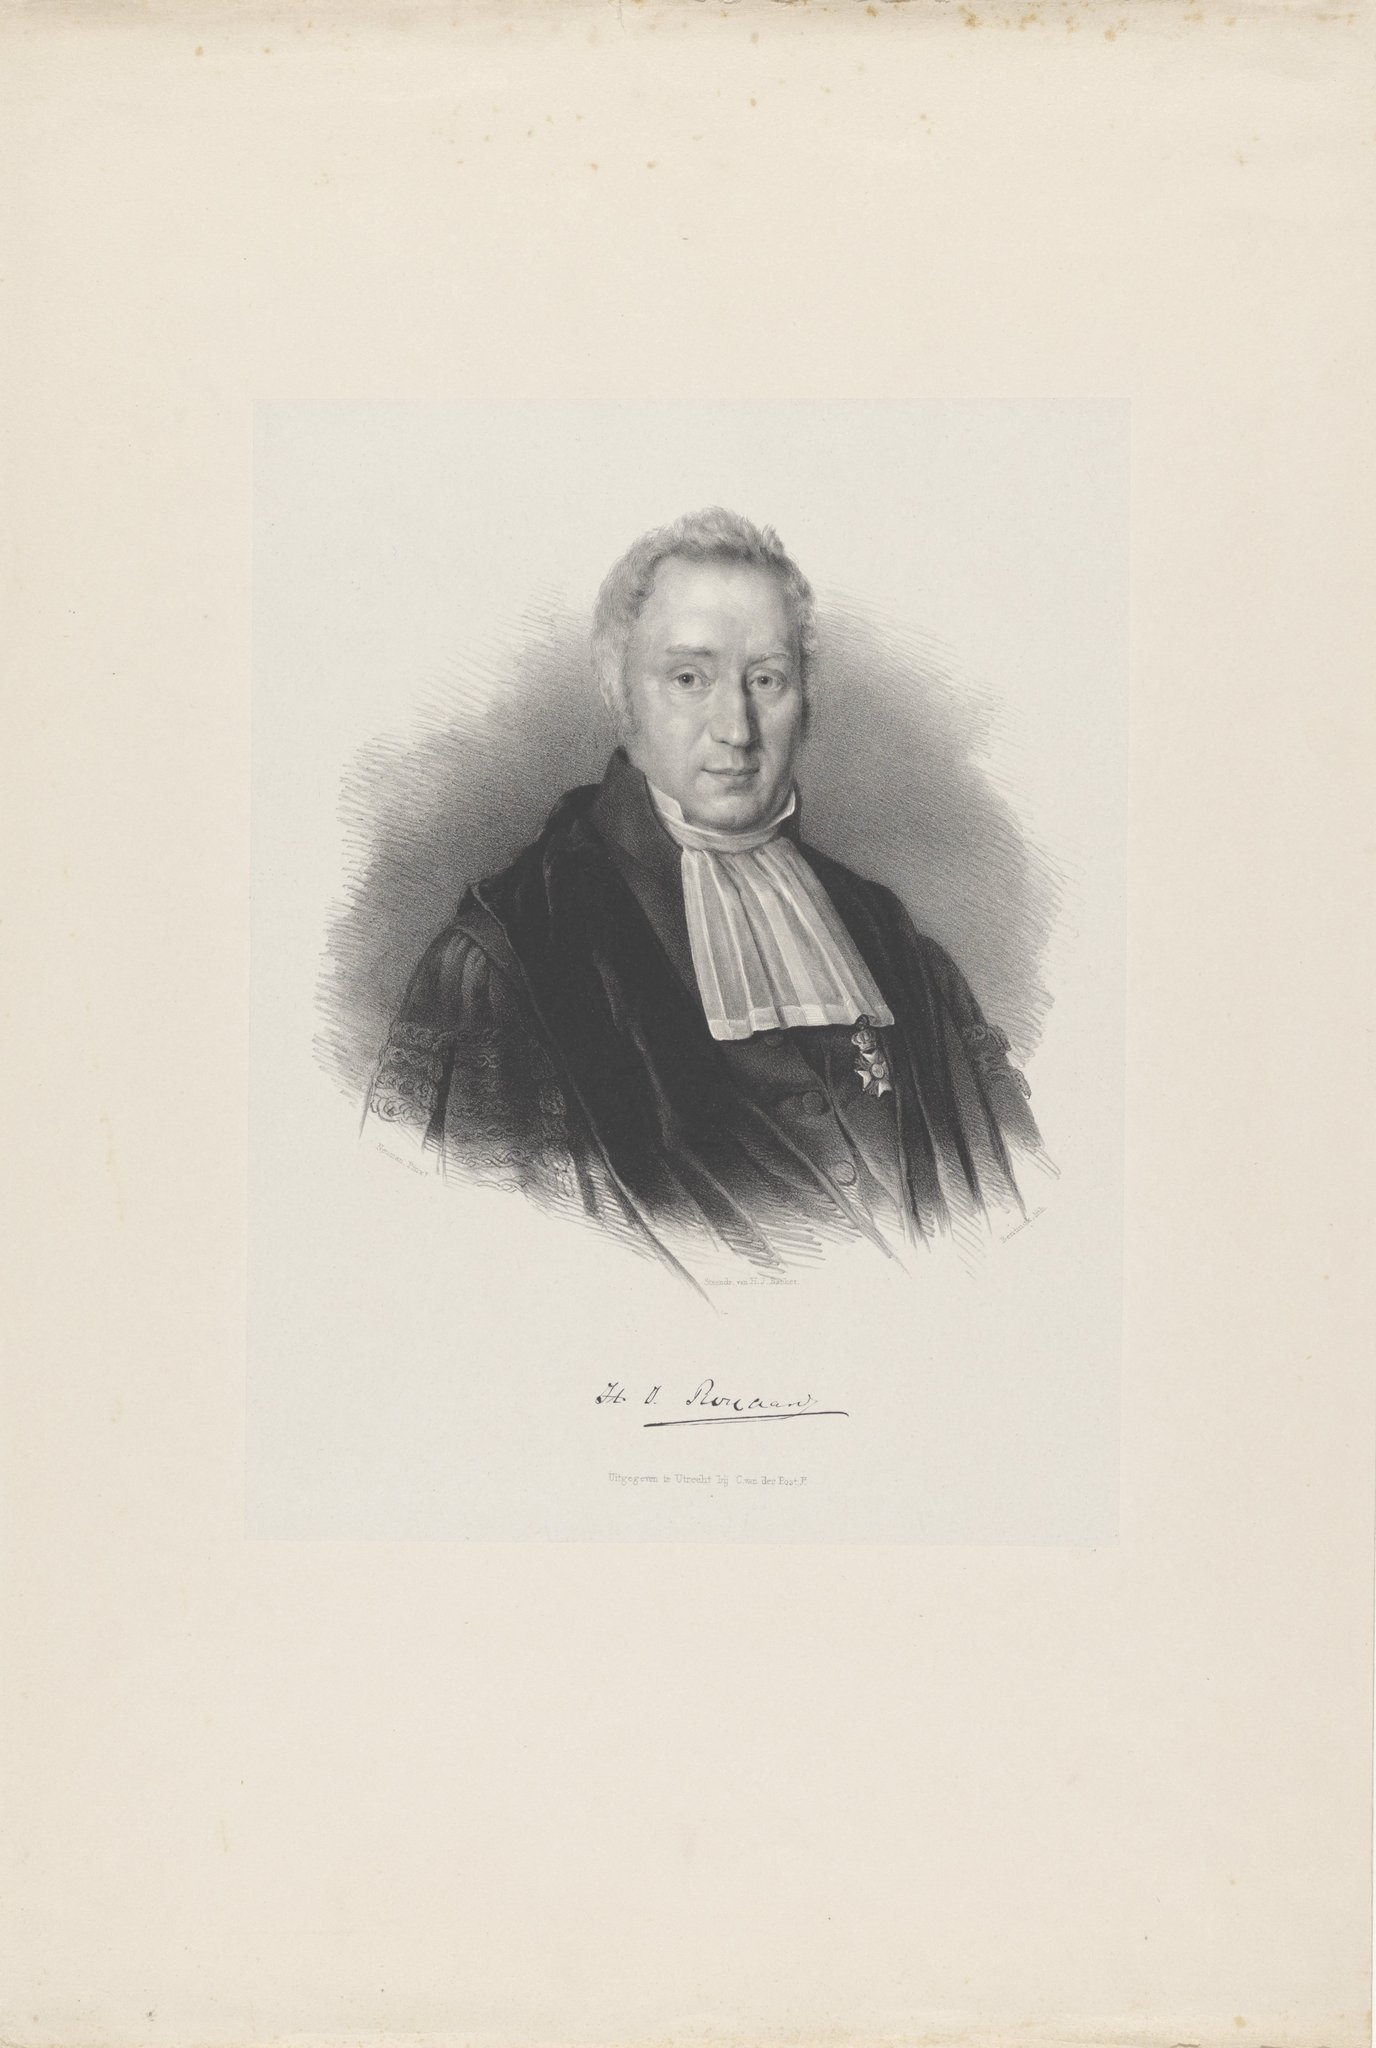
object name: print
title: Portret van theoloog Herman Johan Royaards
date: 1822-1845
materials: paper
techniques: lithograph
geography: utrecht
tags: utrecht, herman johan royaards, knighthood order, historical persons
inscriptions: collector's mark: Lugt 2228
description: De geportretteerde draagt een toga en een ridderorde op zijn borst. Onder het portret de signatuur van de geportretteerde.